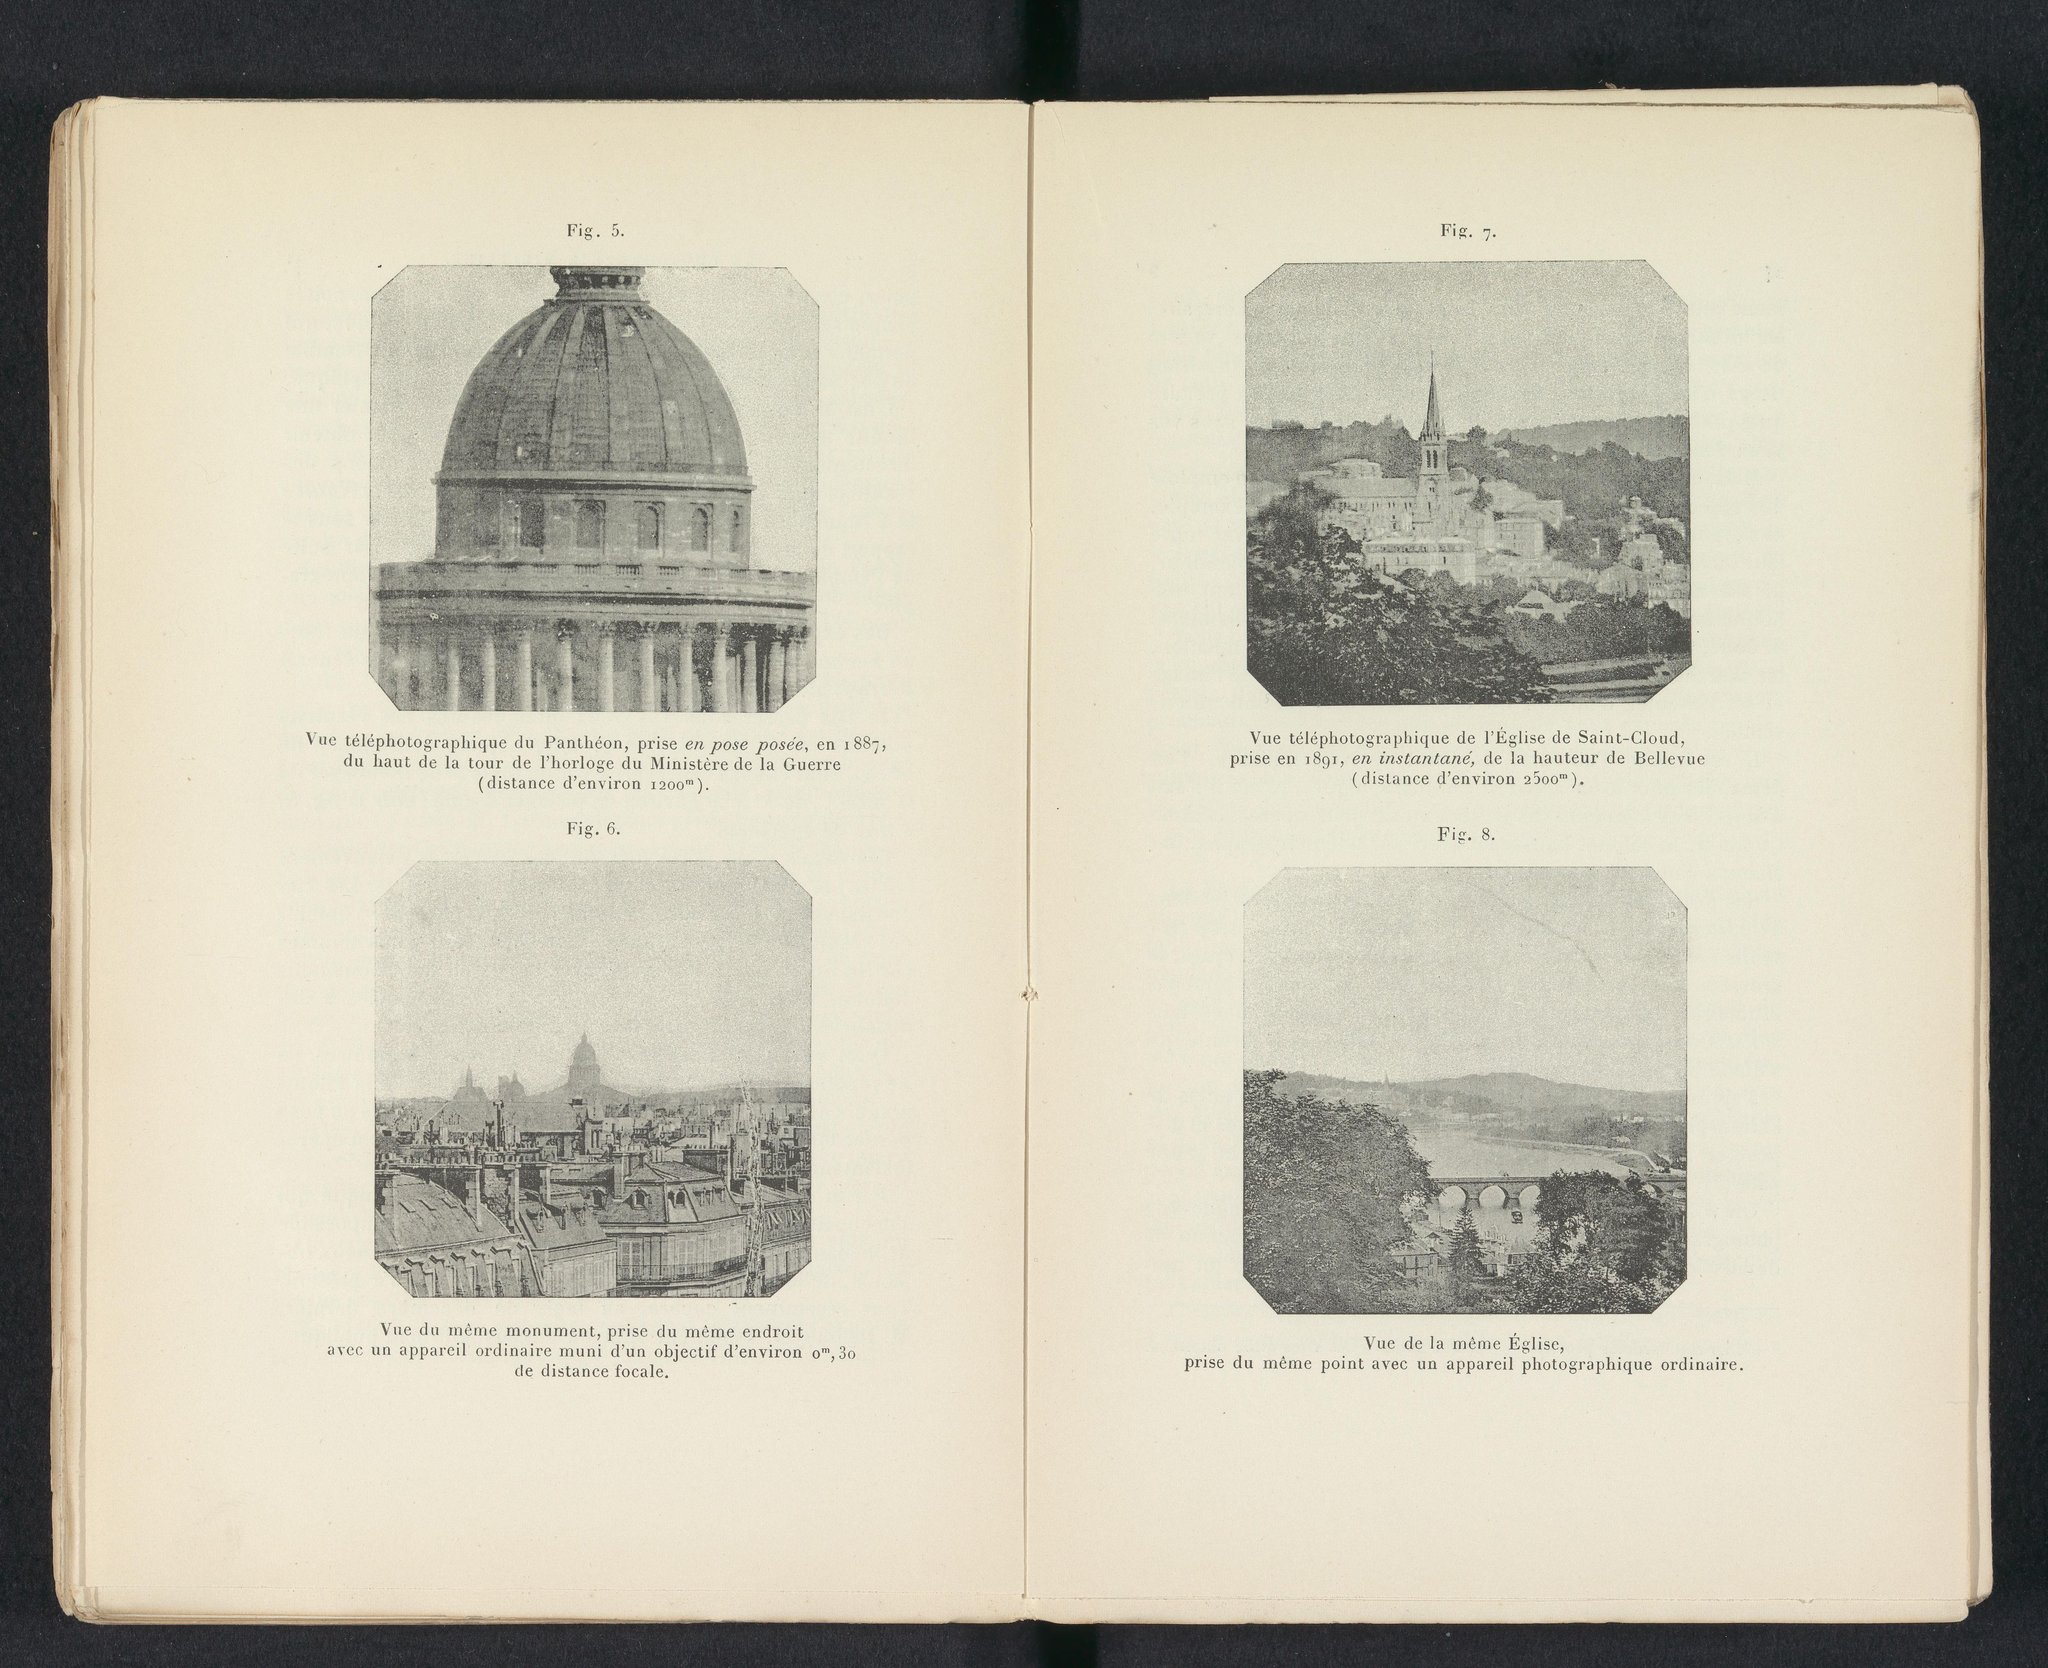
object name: page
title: Twee gezichten op het Panthéon te Parijs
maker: Anonymous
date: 1883-1893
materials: paper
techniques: autotype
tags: city-view in general; 'veduta', façade (of house or building), dome ~ architecture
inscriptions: number: ‘Fig. 5. (...) Fig. 6.’, inscription: ‘Vue téléphotographique (...) de distance focale.’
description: De prent boven is gemaakt met een telelens, onder met een normale lens.